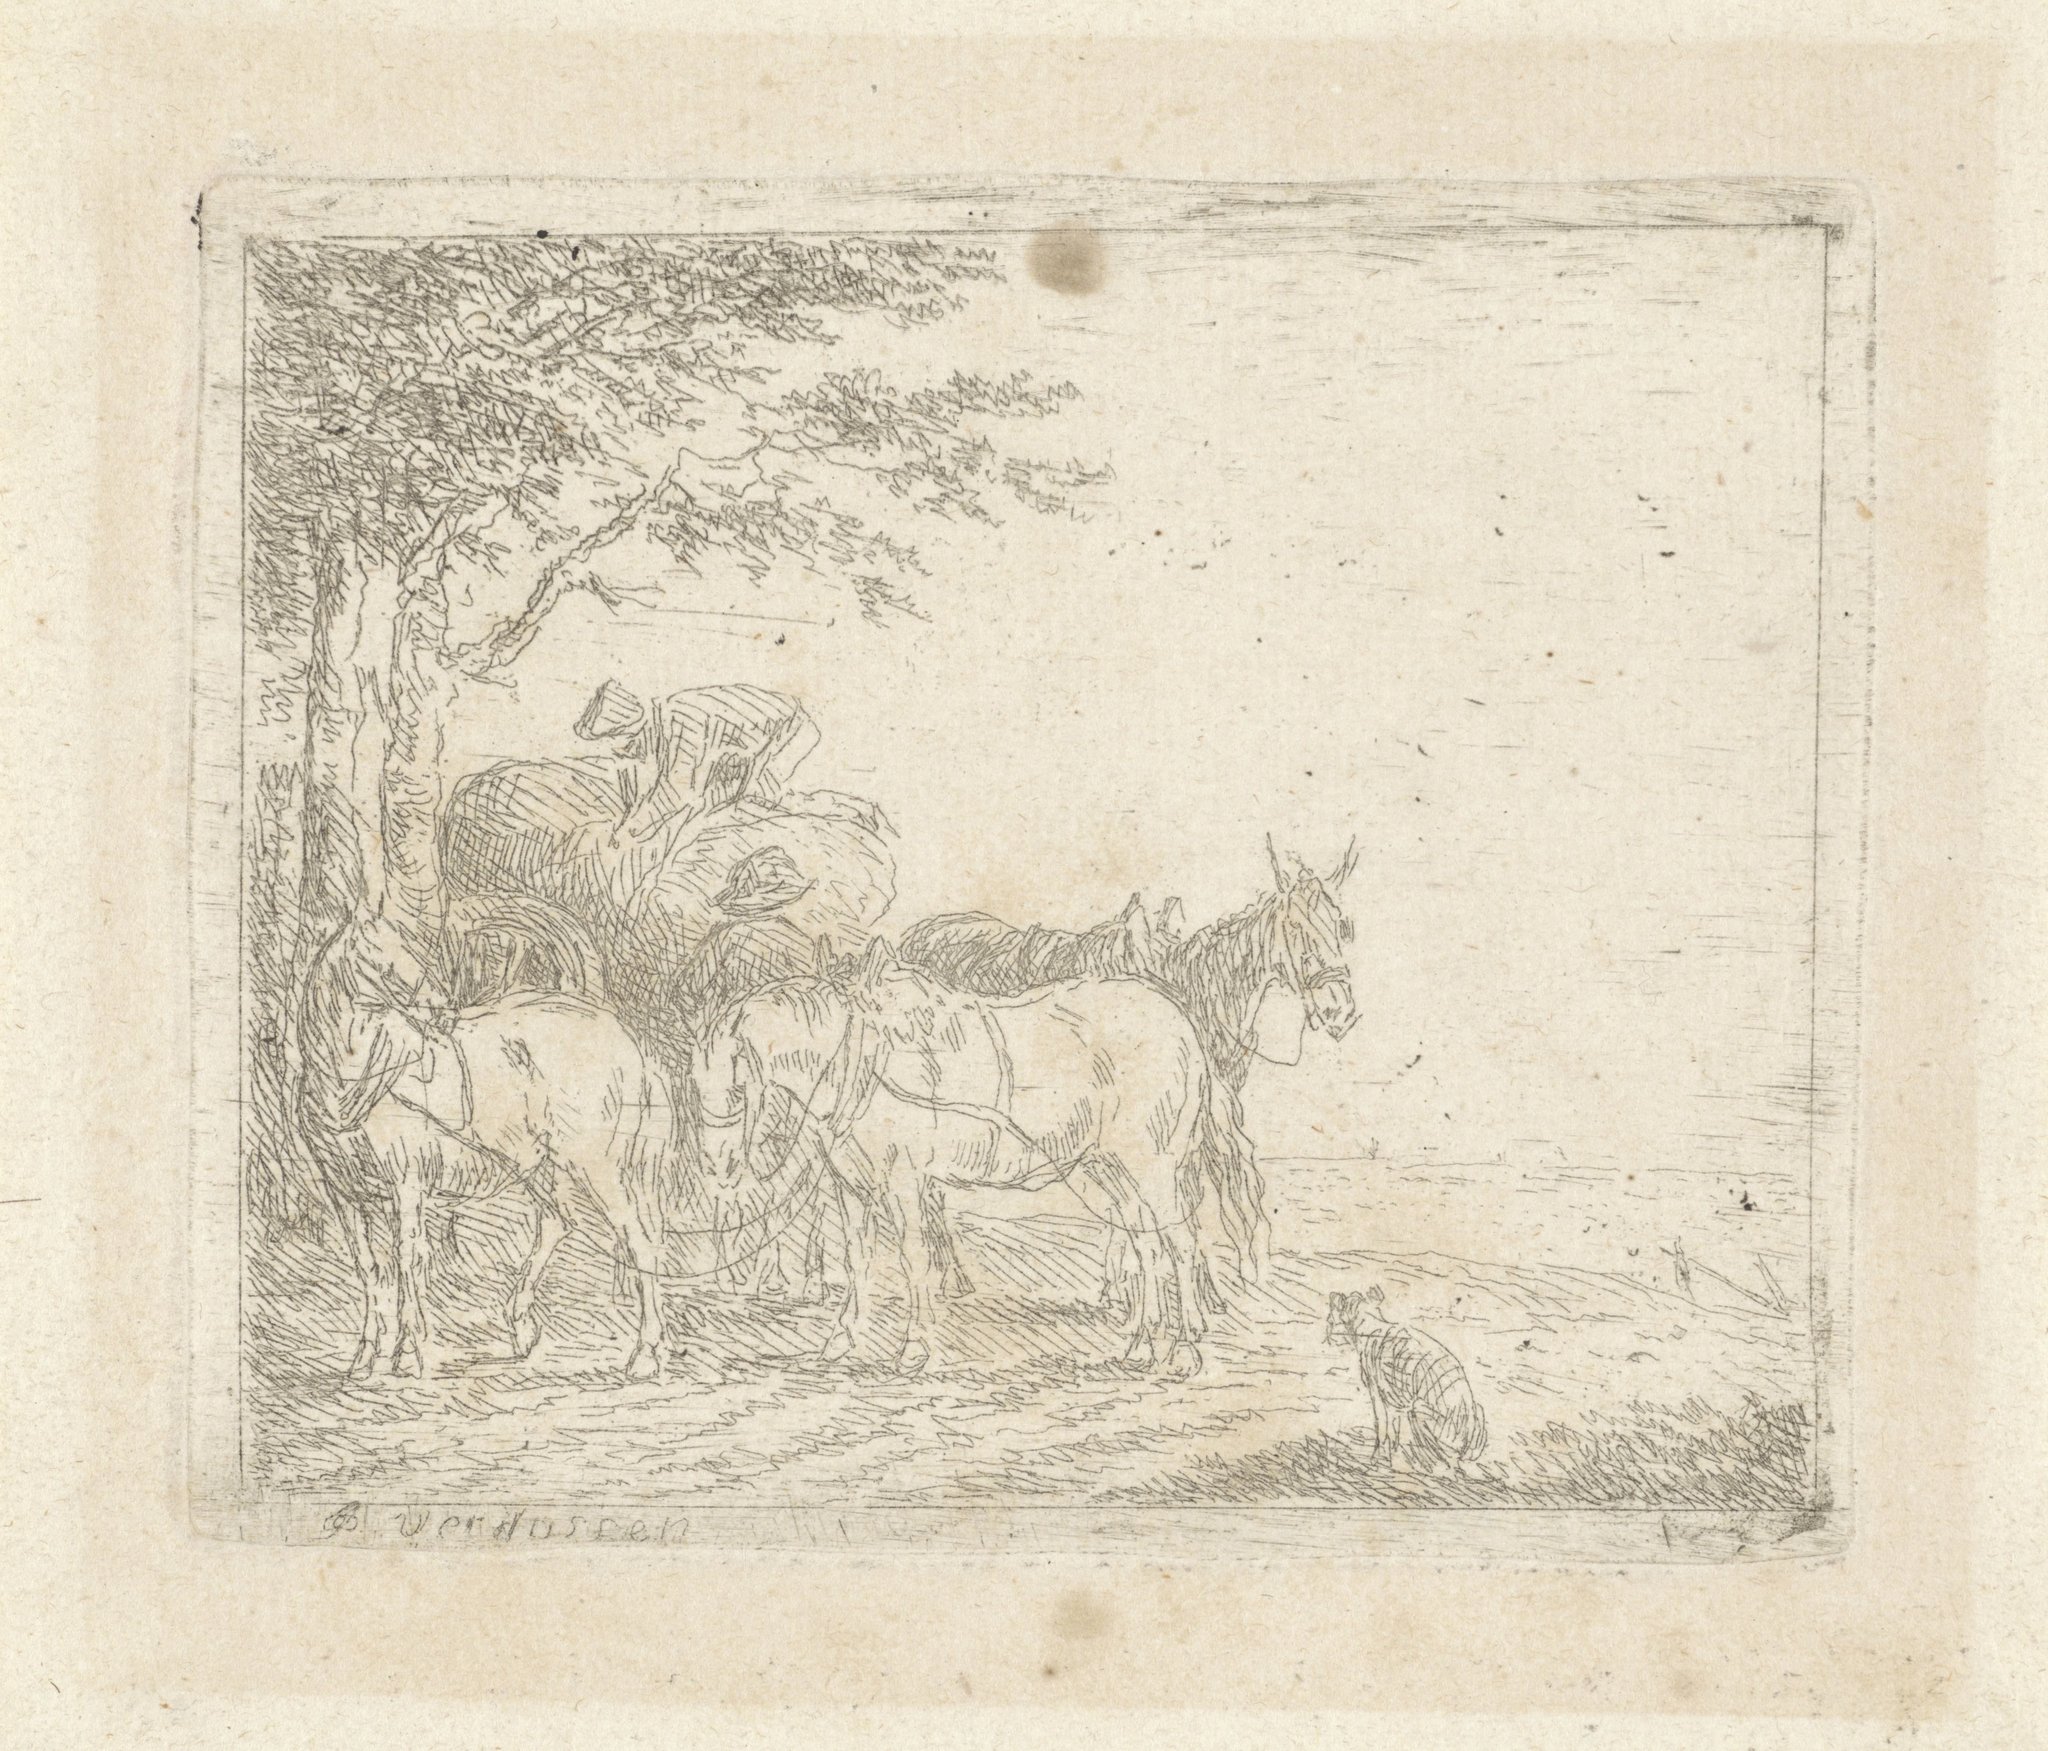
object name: print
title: Drie paarden voor een hooiwagen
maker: jan peeter verdussen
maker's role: print maker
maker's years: 1700-1763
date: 1710-1763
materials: paper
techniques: etching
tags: horse, dog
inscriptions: collector's mark: Lugt 2228, collector's mark: Lugt 2760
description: Twee figuren maken een hooiwagen gereed, met drie paarden. rechts een hond.